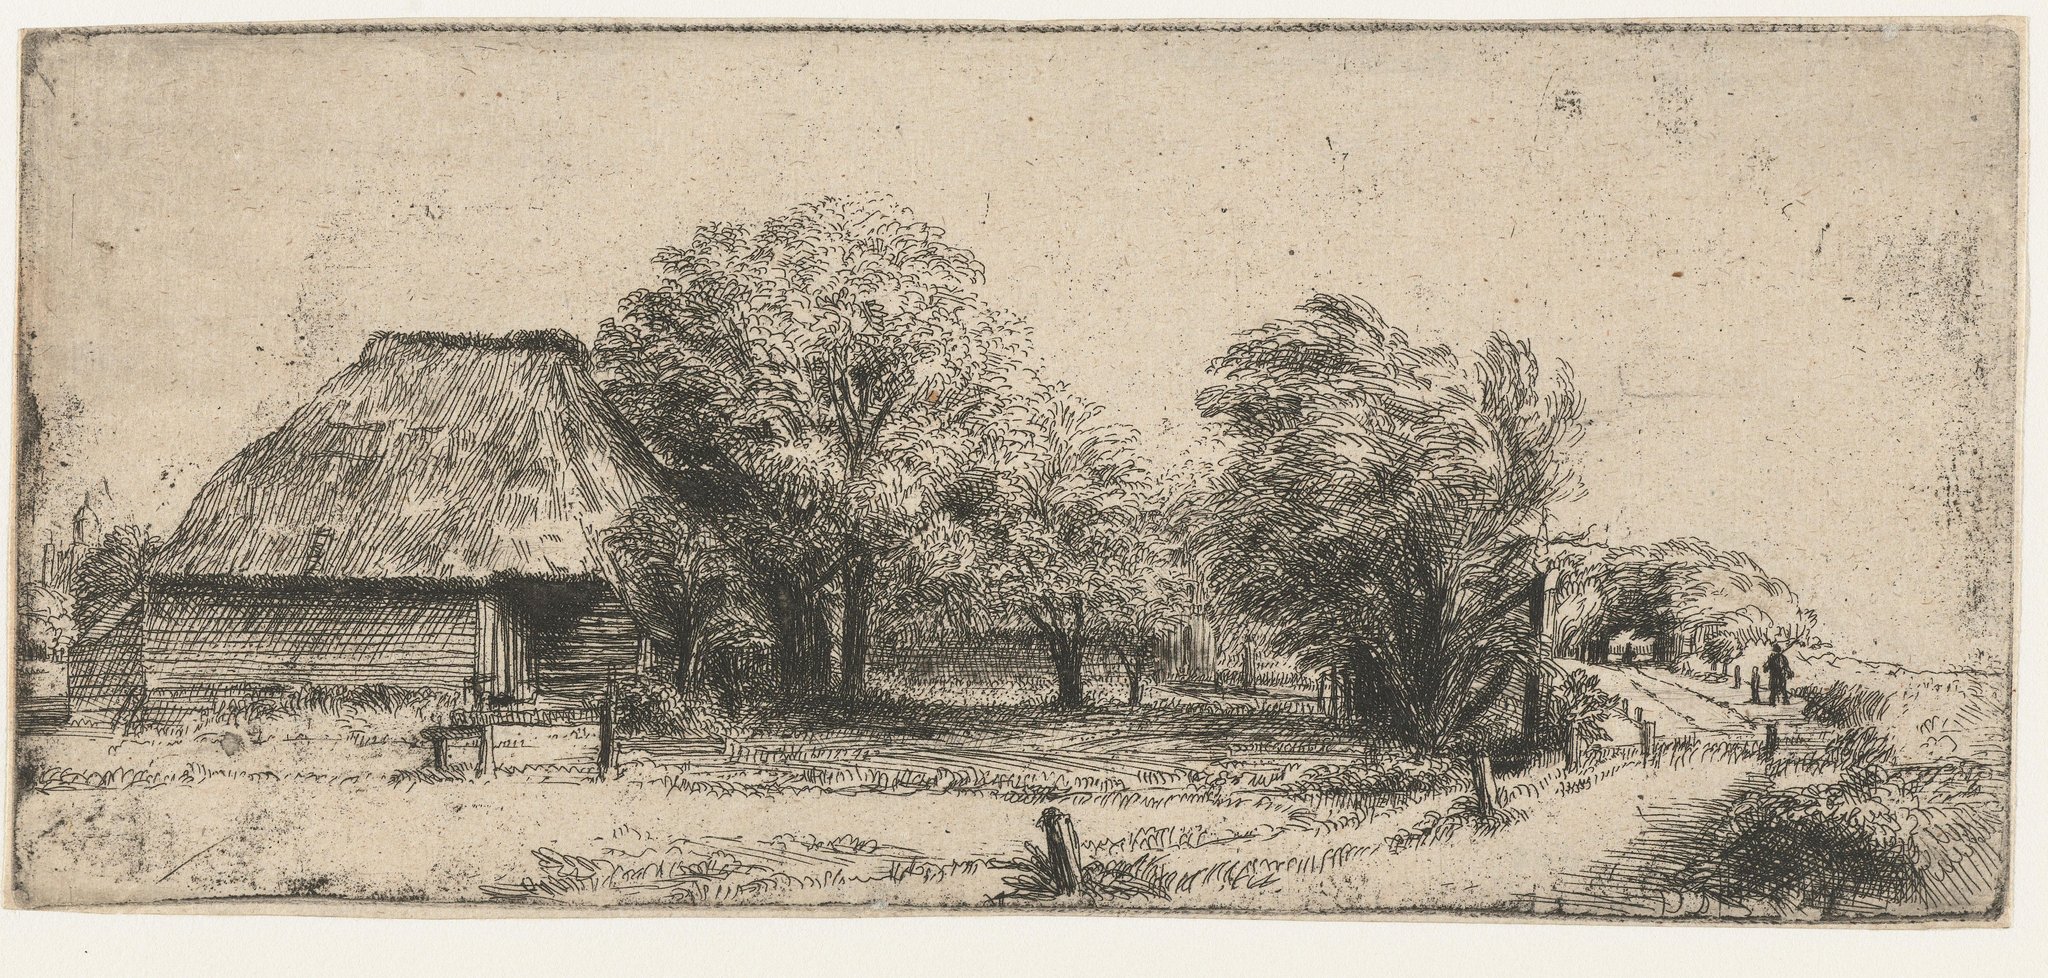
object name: print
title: Boomgaard met een schuur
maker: Anonymous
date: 1630-1700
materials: paper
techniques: etching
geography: netherlands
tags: barn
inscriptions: collector's mark: Lugt 240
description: De signatuur P.D.W. die Seidlitz ziet, zijn waarschijnlijk alleen schaduwlijnen.